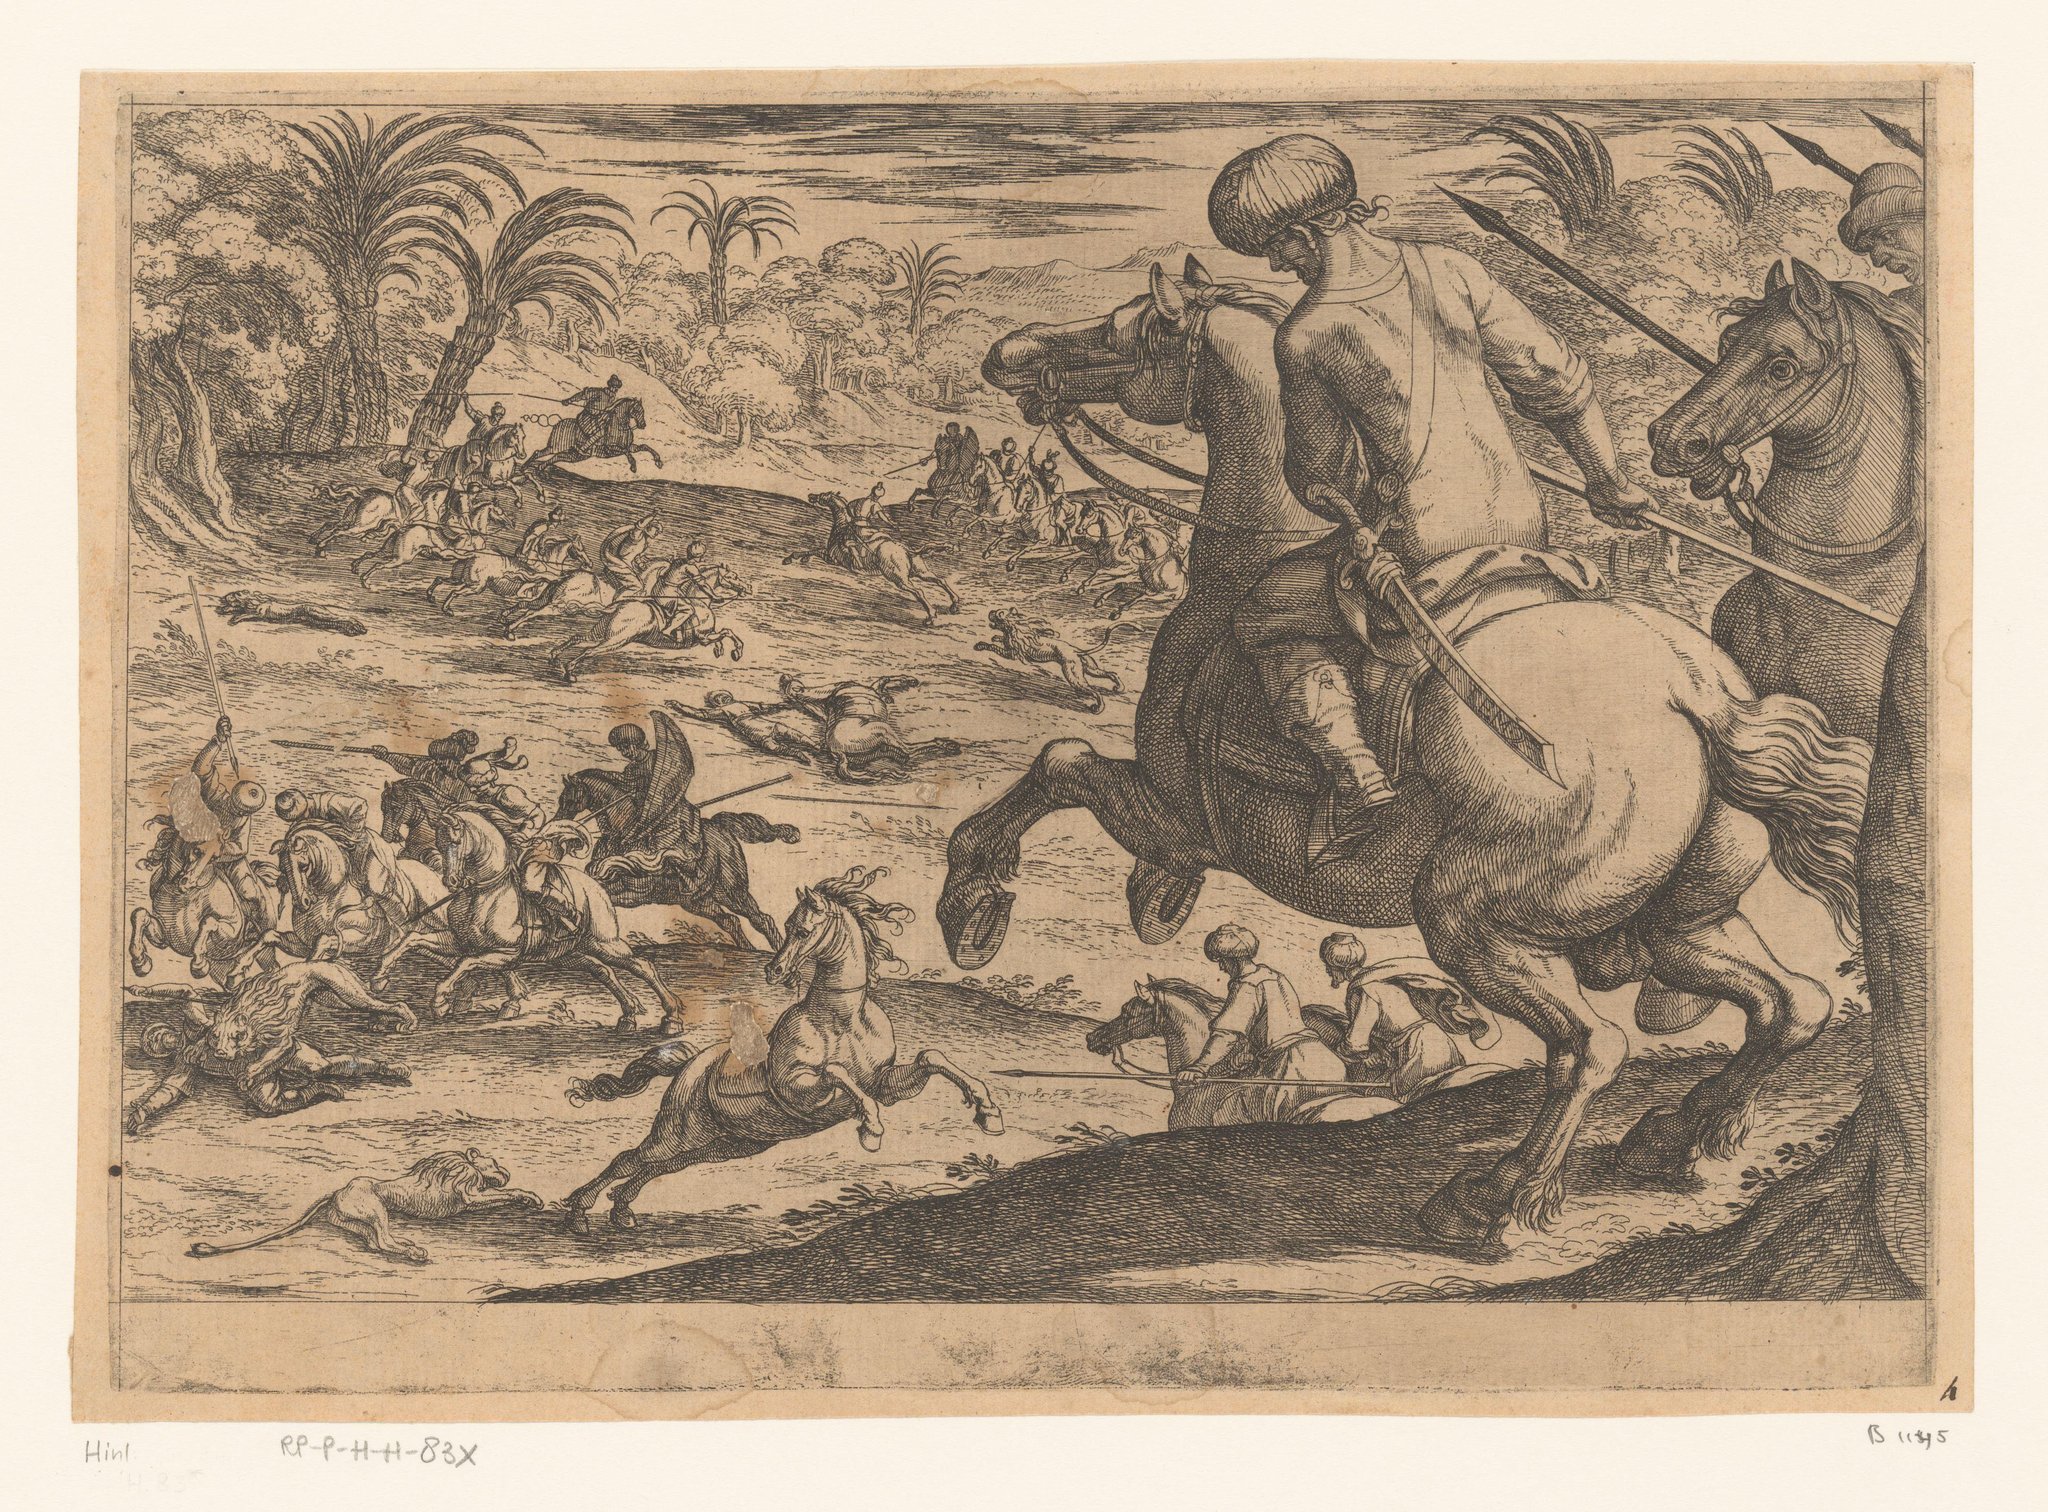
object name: print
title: Jacht op leeuwen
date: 1609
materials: paper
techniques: etching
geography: vatican city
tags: hunter, hunters hunting (n.b.: in 1988-1990 this notation denoted the concept of 43c11421 'hunters resting during the hunt')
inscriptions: number: ‘4’, collector's mark: Lugt 11, collector's mark: ‘Hinloopen’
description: Deze prent maakt deel uit van een reeks van negen prenten met jachtscènes (+ opdracht).